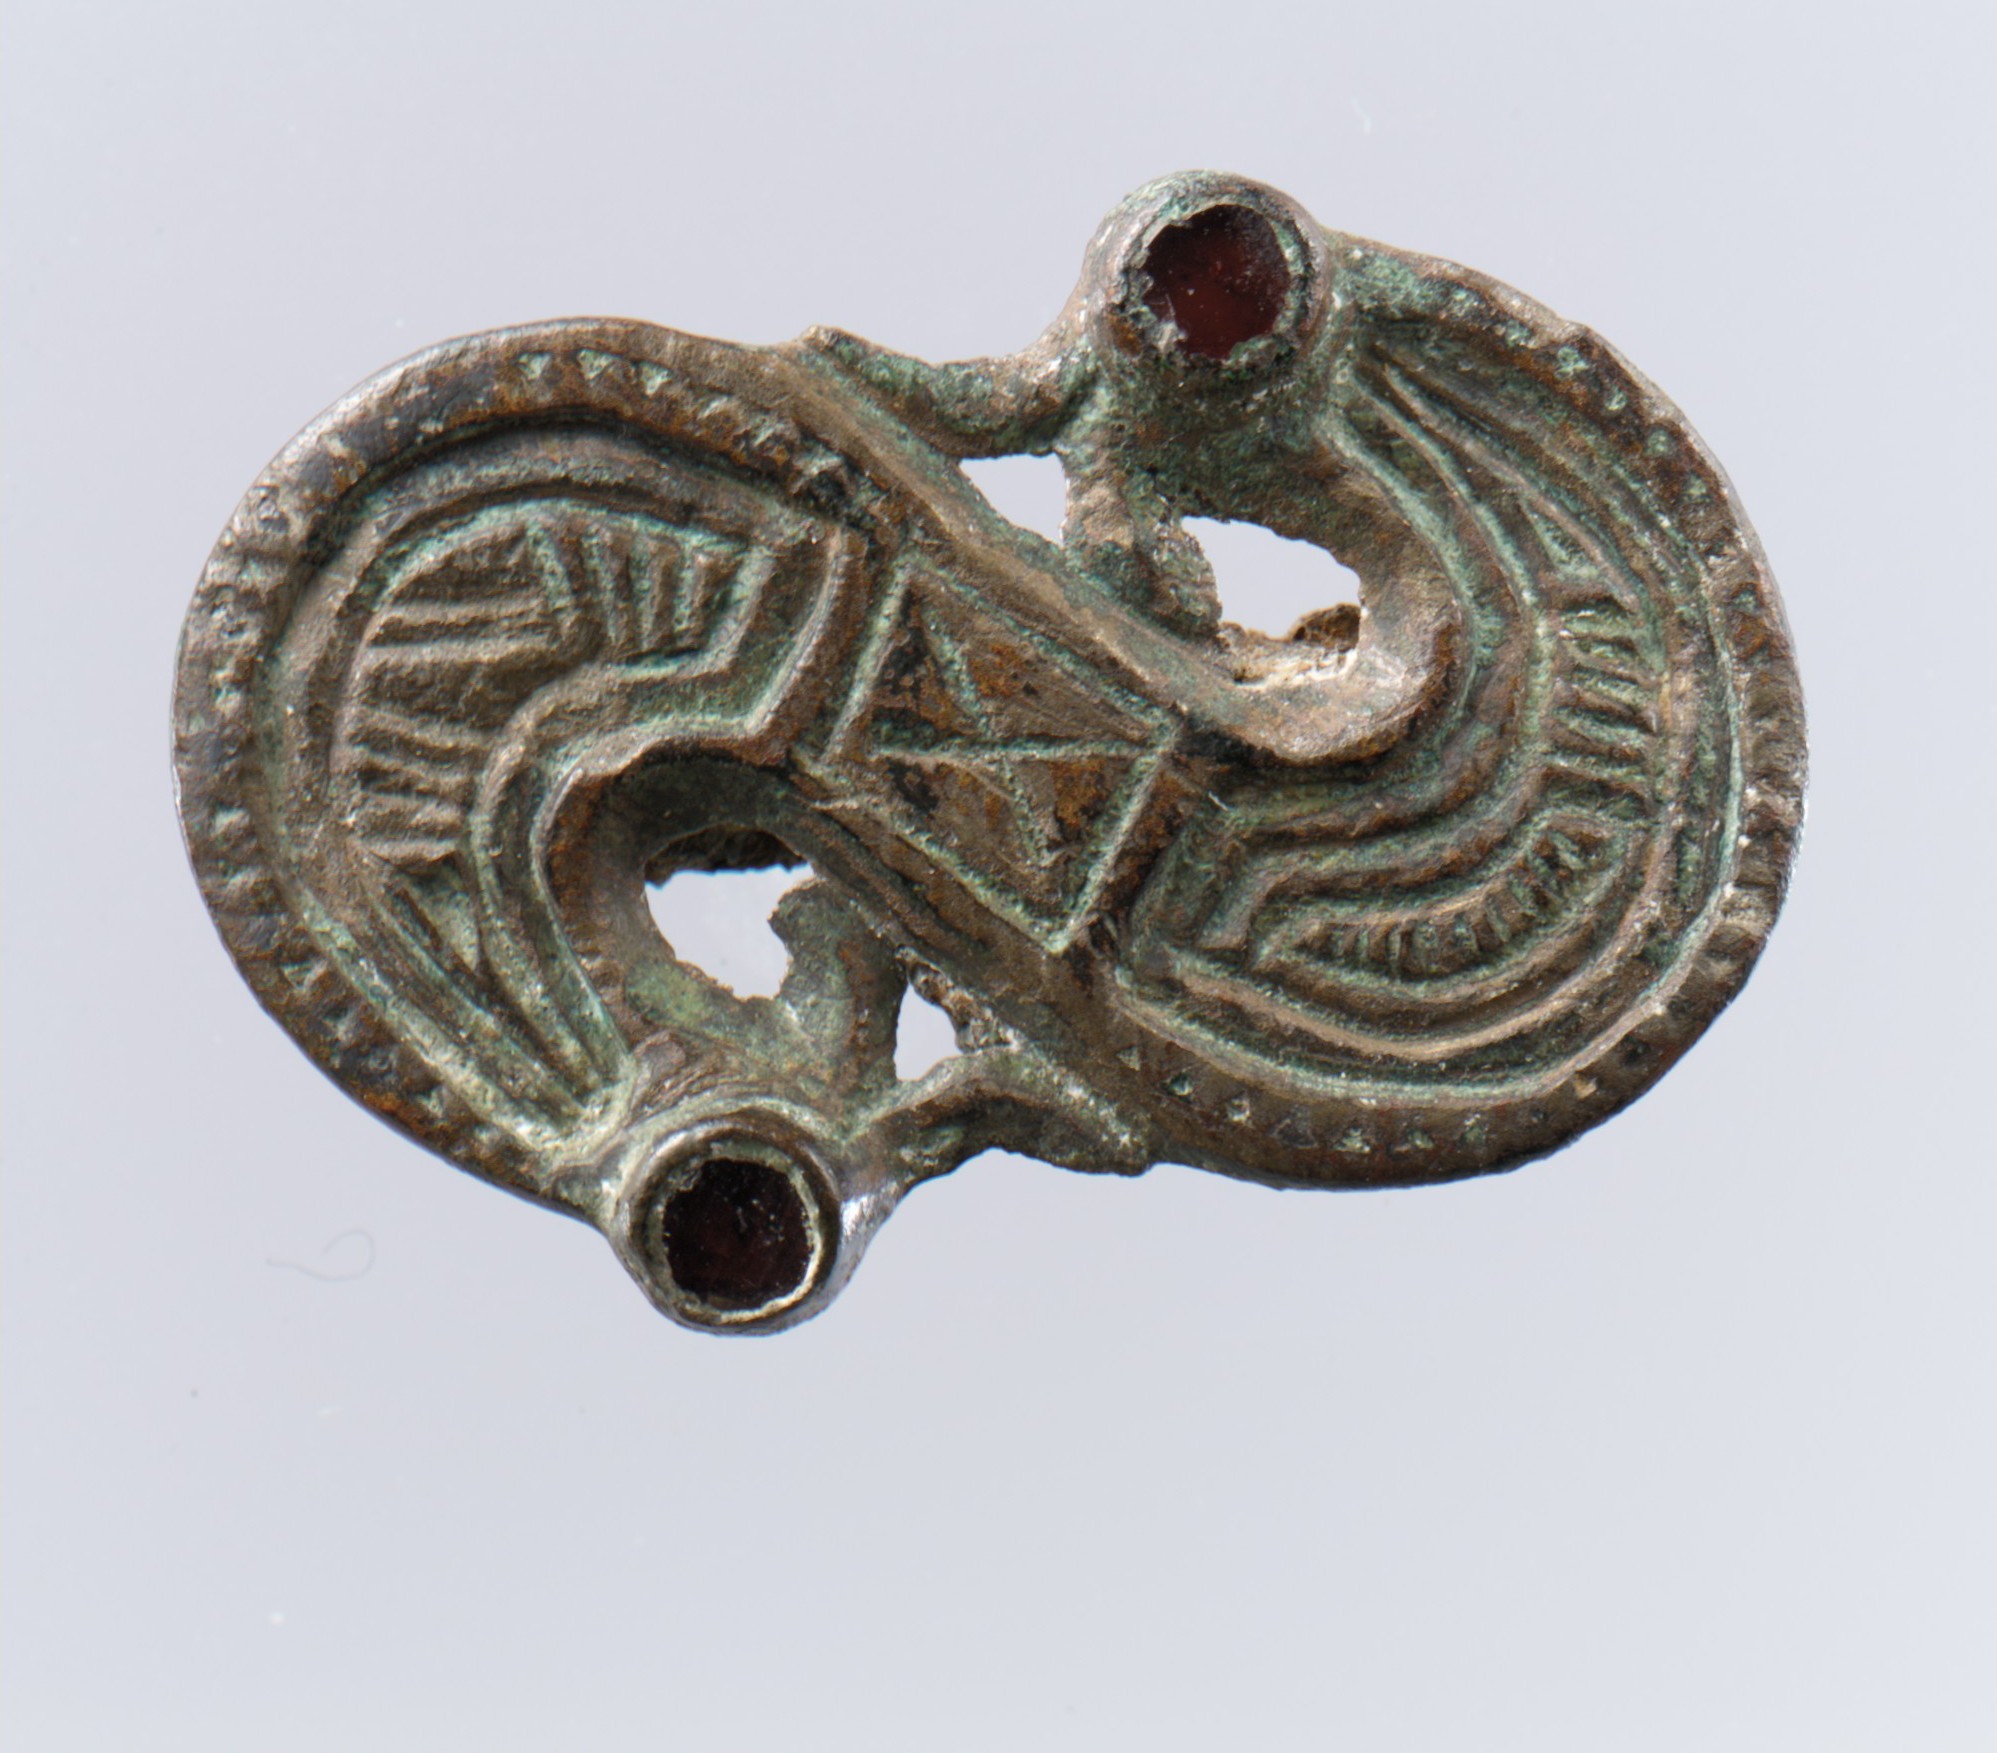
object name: brooch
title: S-Shaped Brooch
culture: frankish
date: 601-700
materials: copper alloy, gemstone